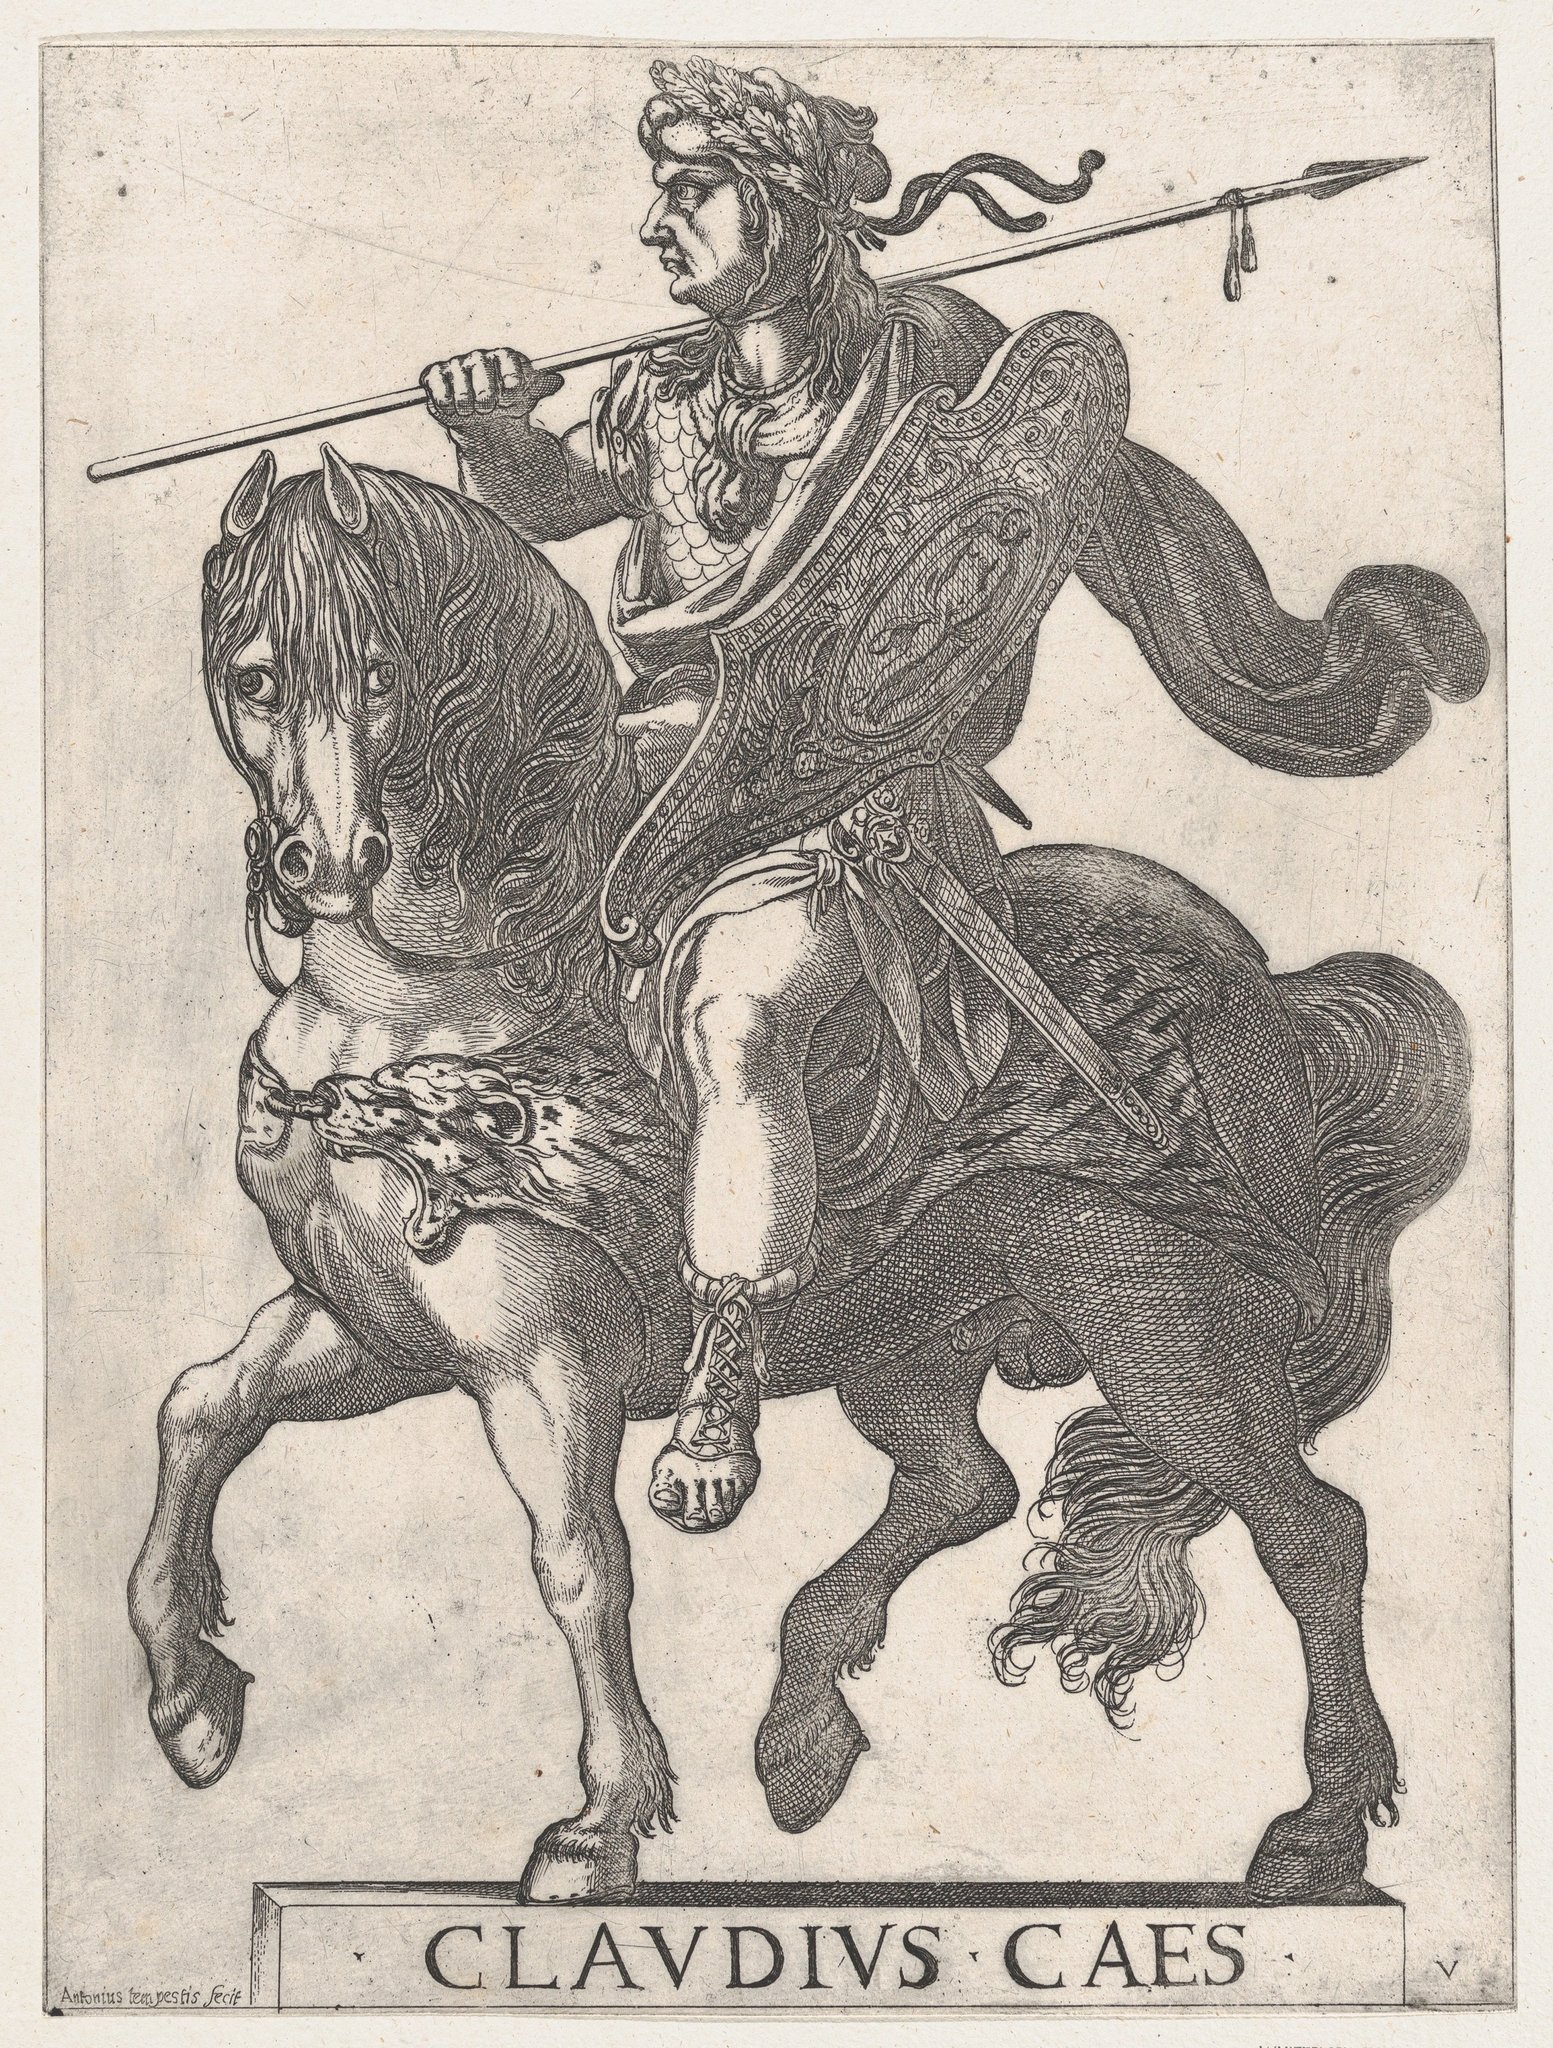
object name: print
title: Plate 5: Emperor Claudius on Horseback, from 'The First Twelve Roman Caesars'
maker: antonio tempesta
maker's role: artist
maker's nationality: italian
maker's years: 1555-1630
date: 1596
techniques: etching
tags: men,horses